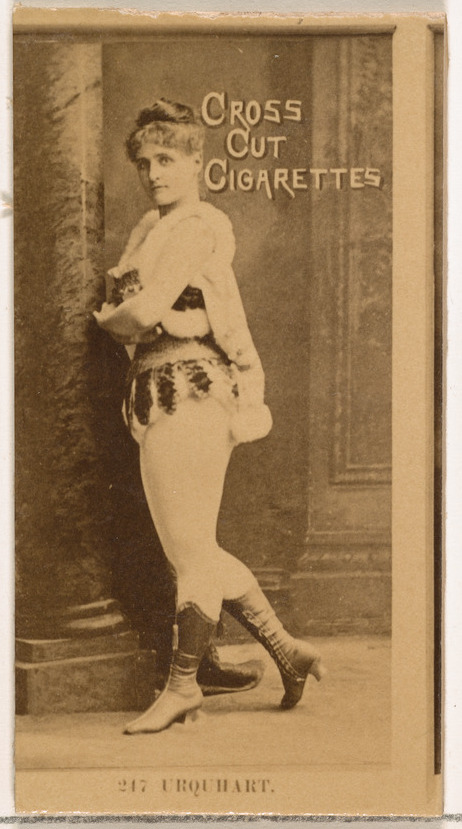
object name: print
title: Card Number 247, Urquhart, from the Actors and Actresses series (N145-2) issued by Duke Sons & Co. to promote Cross Cut Cigarettes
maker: w. duke, sons & co.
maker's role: publisher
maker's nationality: american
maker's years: 1870-1920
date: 1880-1889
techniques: albumen silver print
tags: portraits,women,actresses